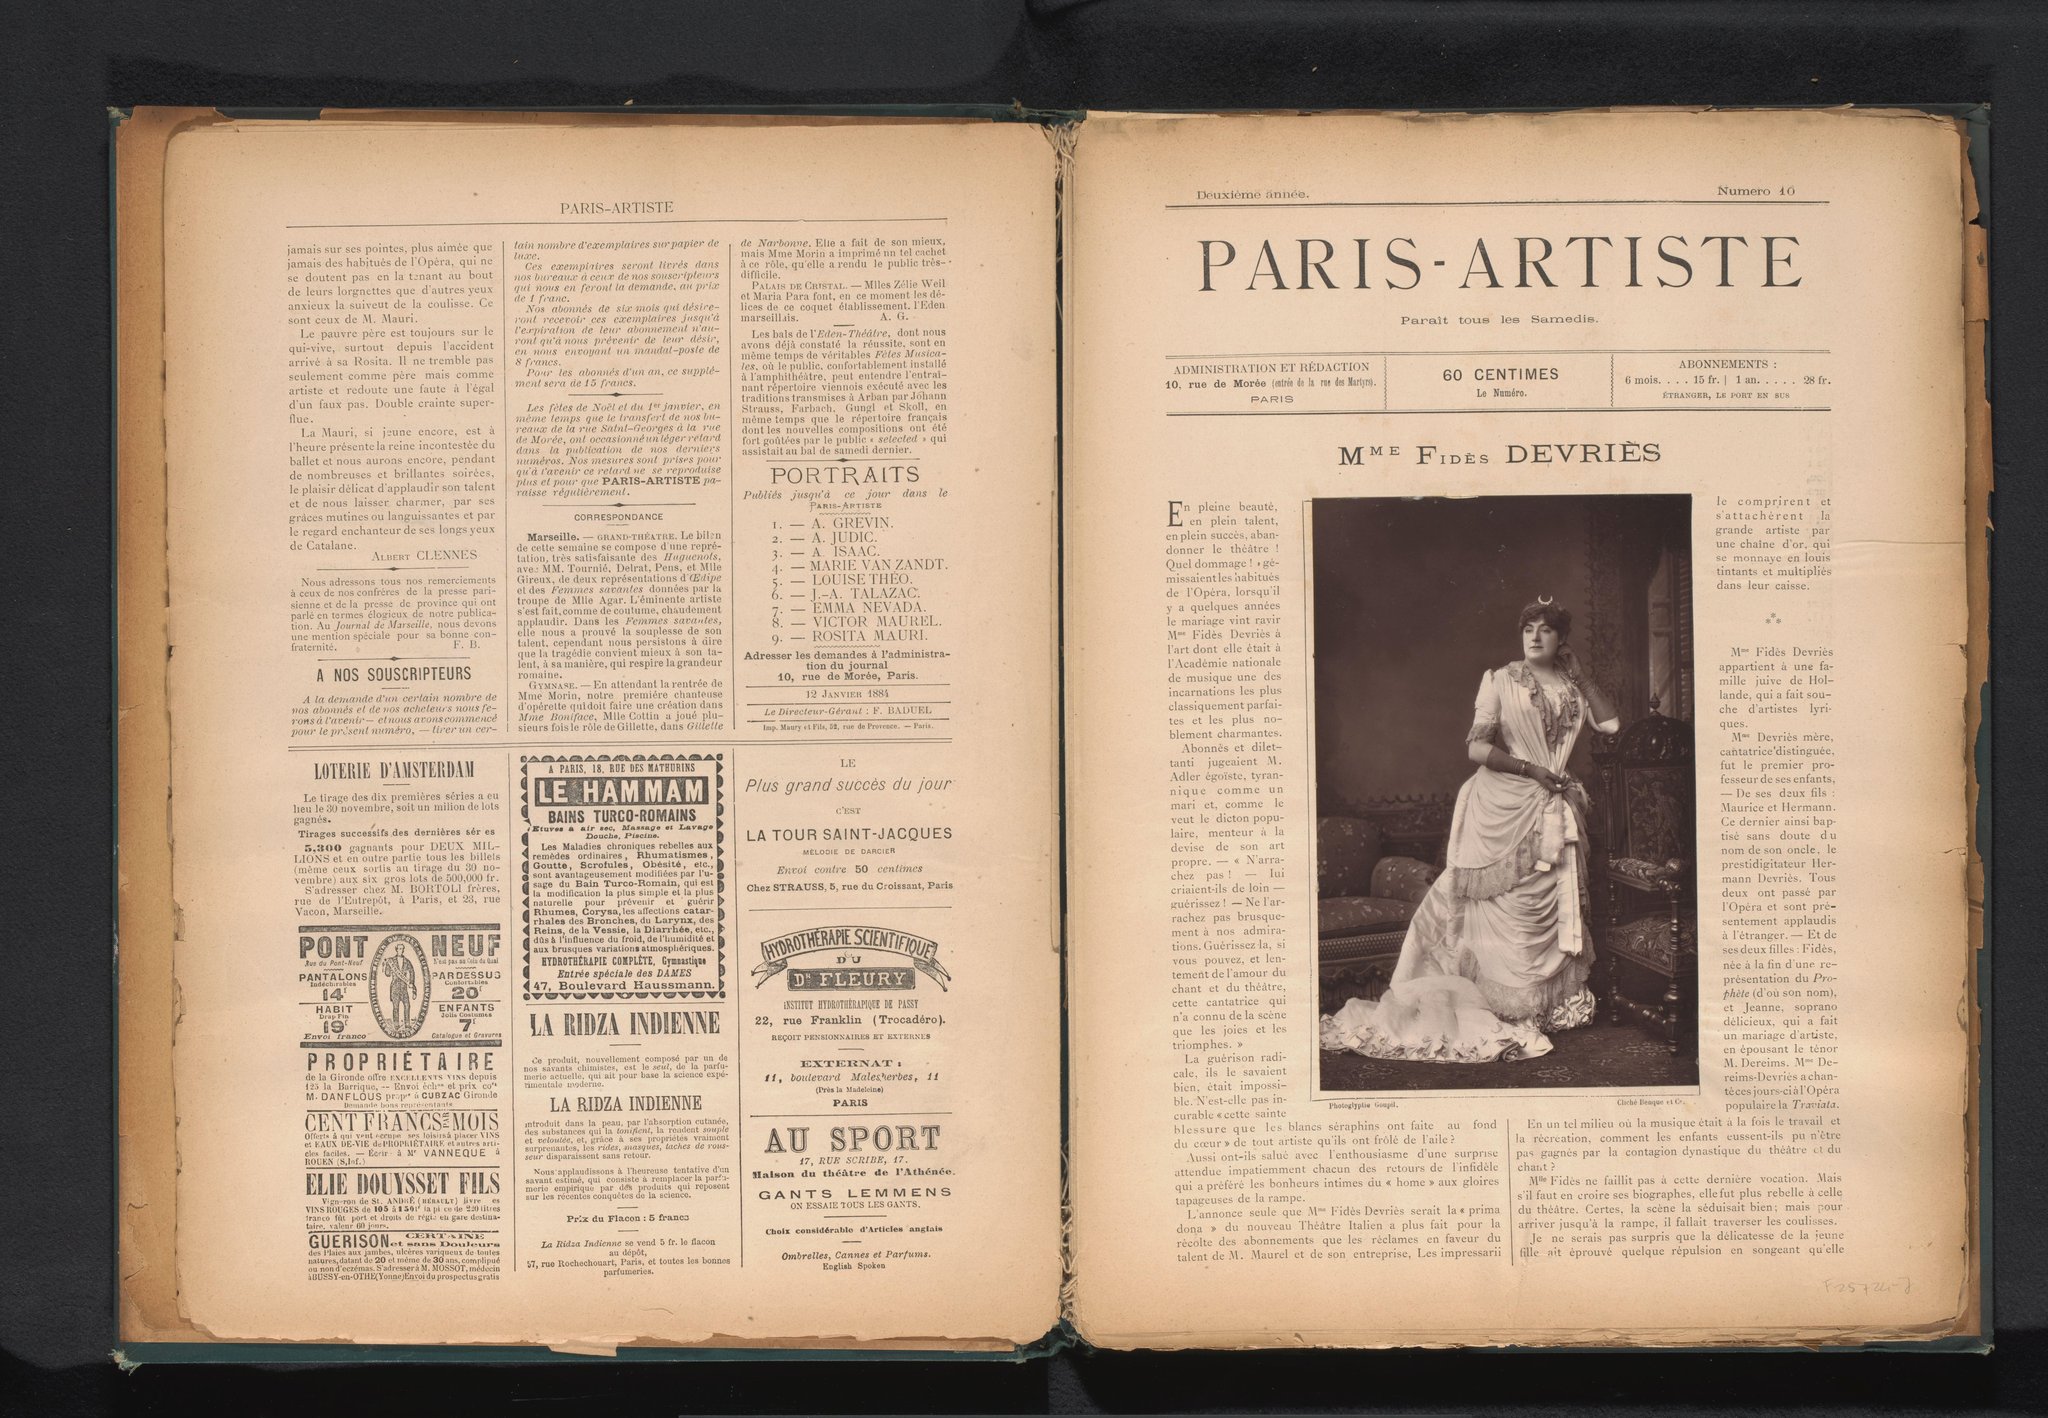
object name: page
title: Portret van Fidès Devriès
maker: wilhelm benque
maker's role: fotograaf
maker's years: 1843-1903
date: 1878-1883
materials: paper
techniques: woodburytype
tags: historical persons - bb - woman, female singer